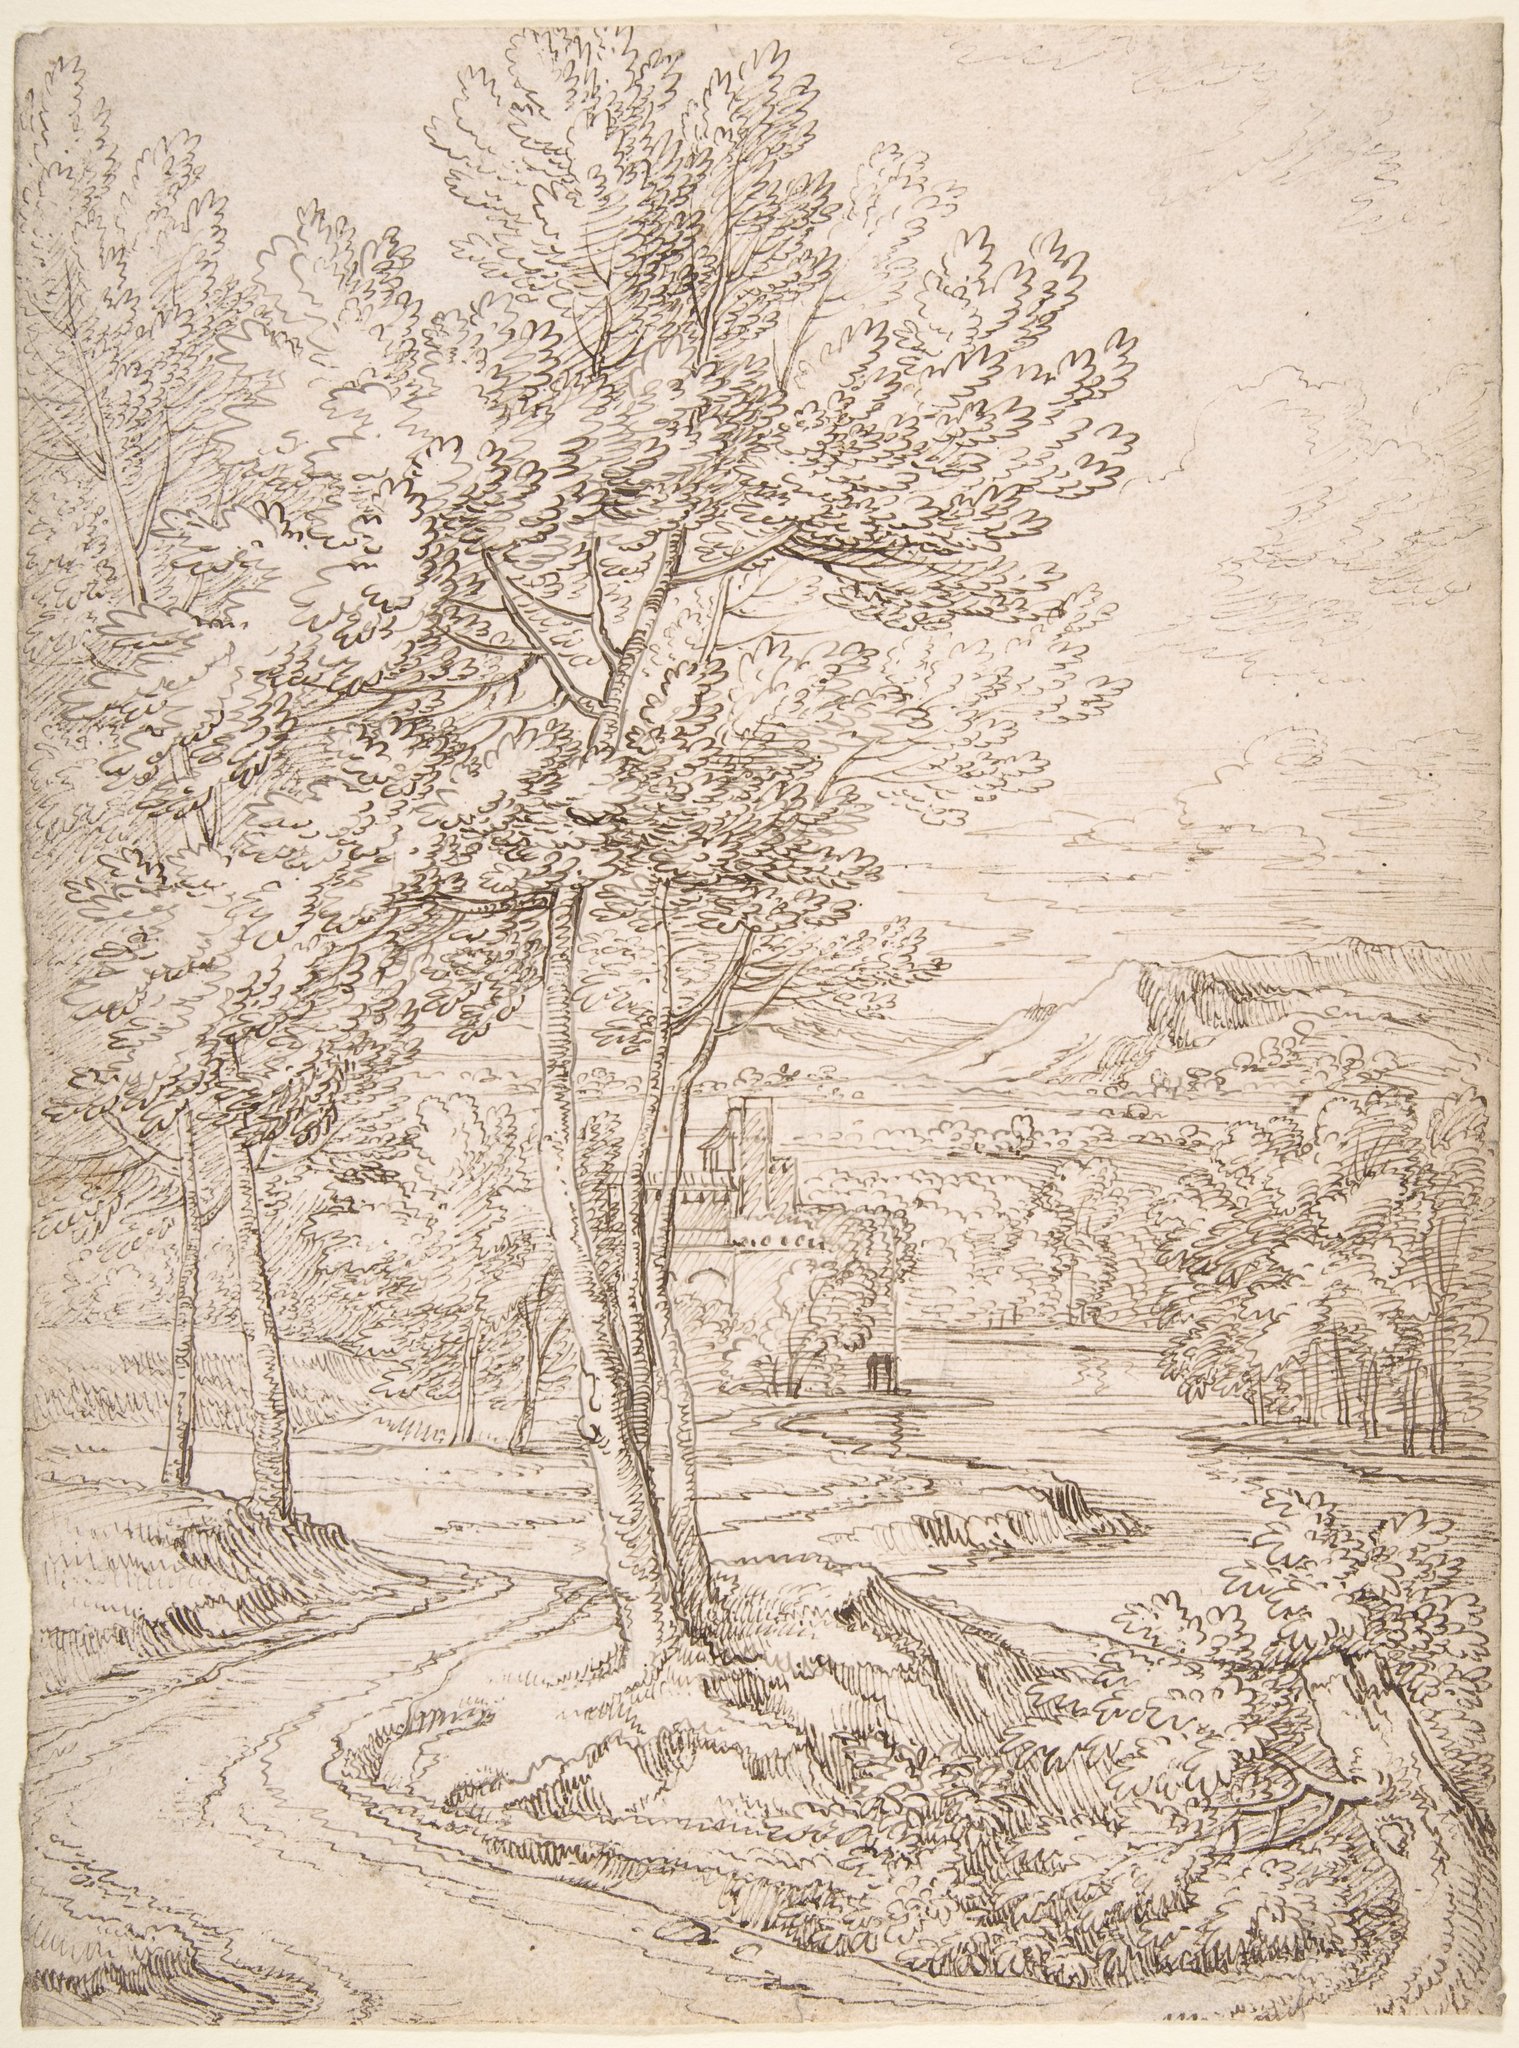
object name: drawing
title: Classical Landscape with a Building and a River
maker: abraham genoels ii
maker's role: artist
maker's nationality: flemish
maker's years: 1640-1723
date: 1601-1733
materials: ink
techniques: pen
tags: buildings,trees